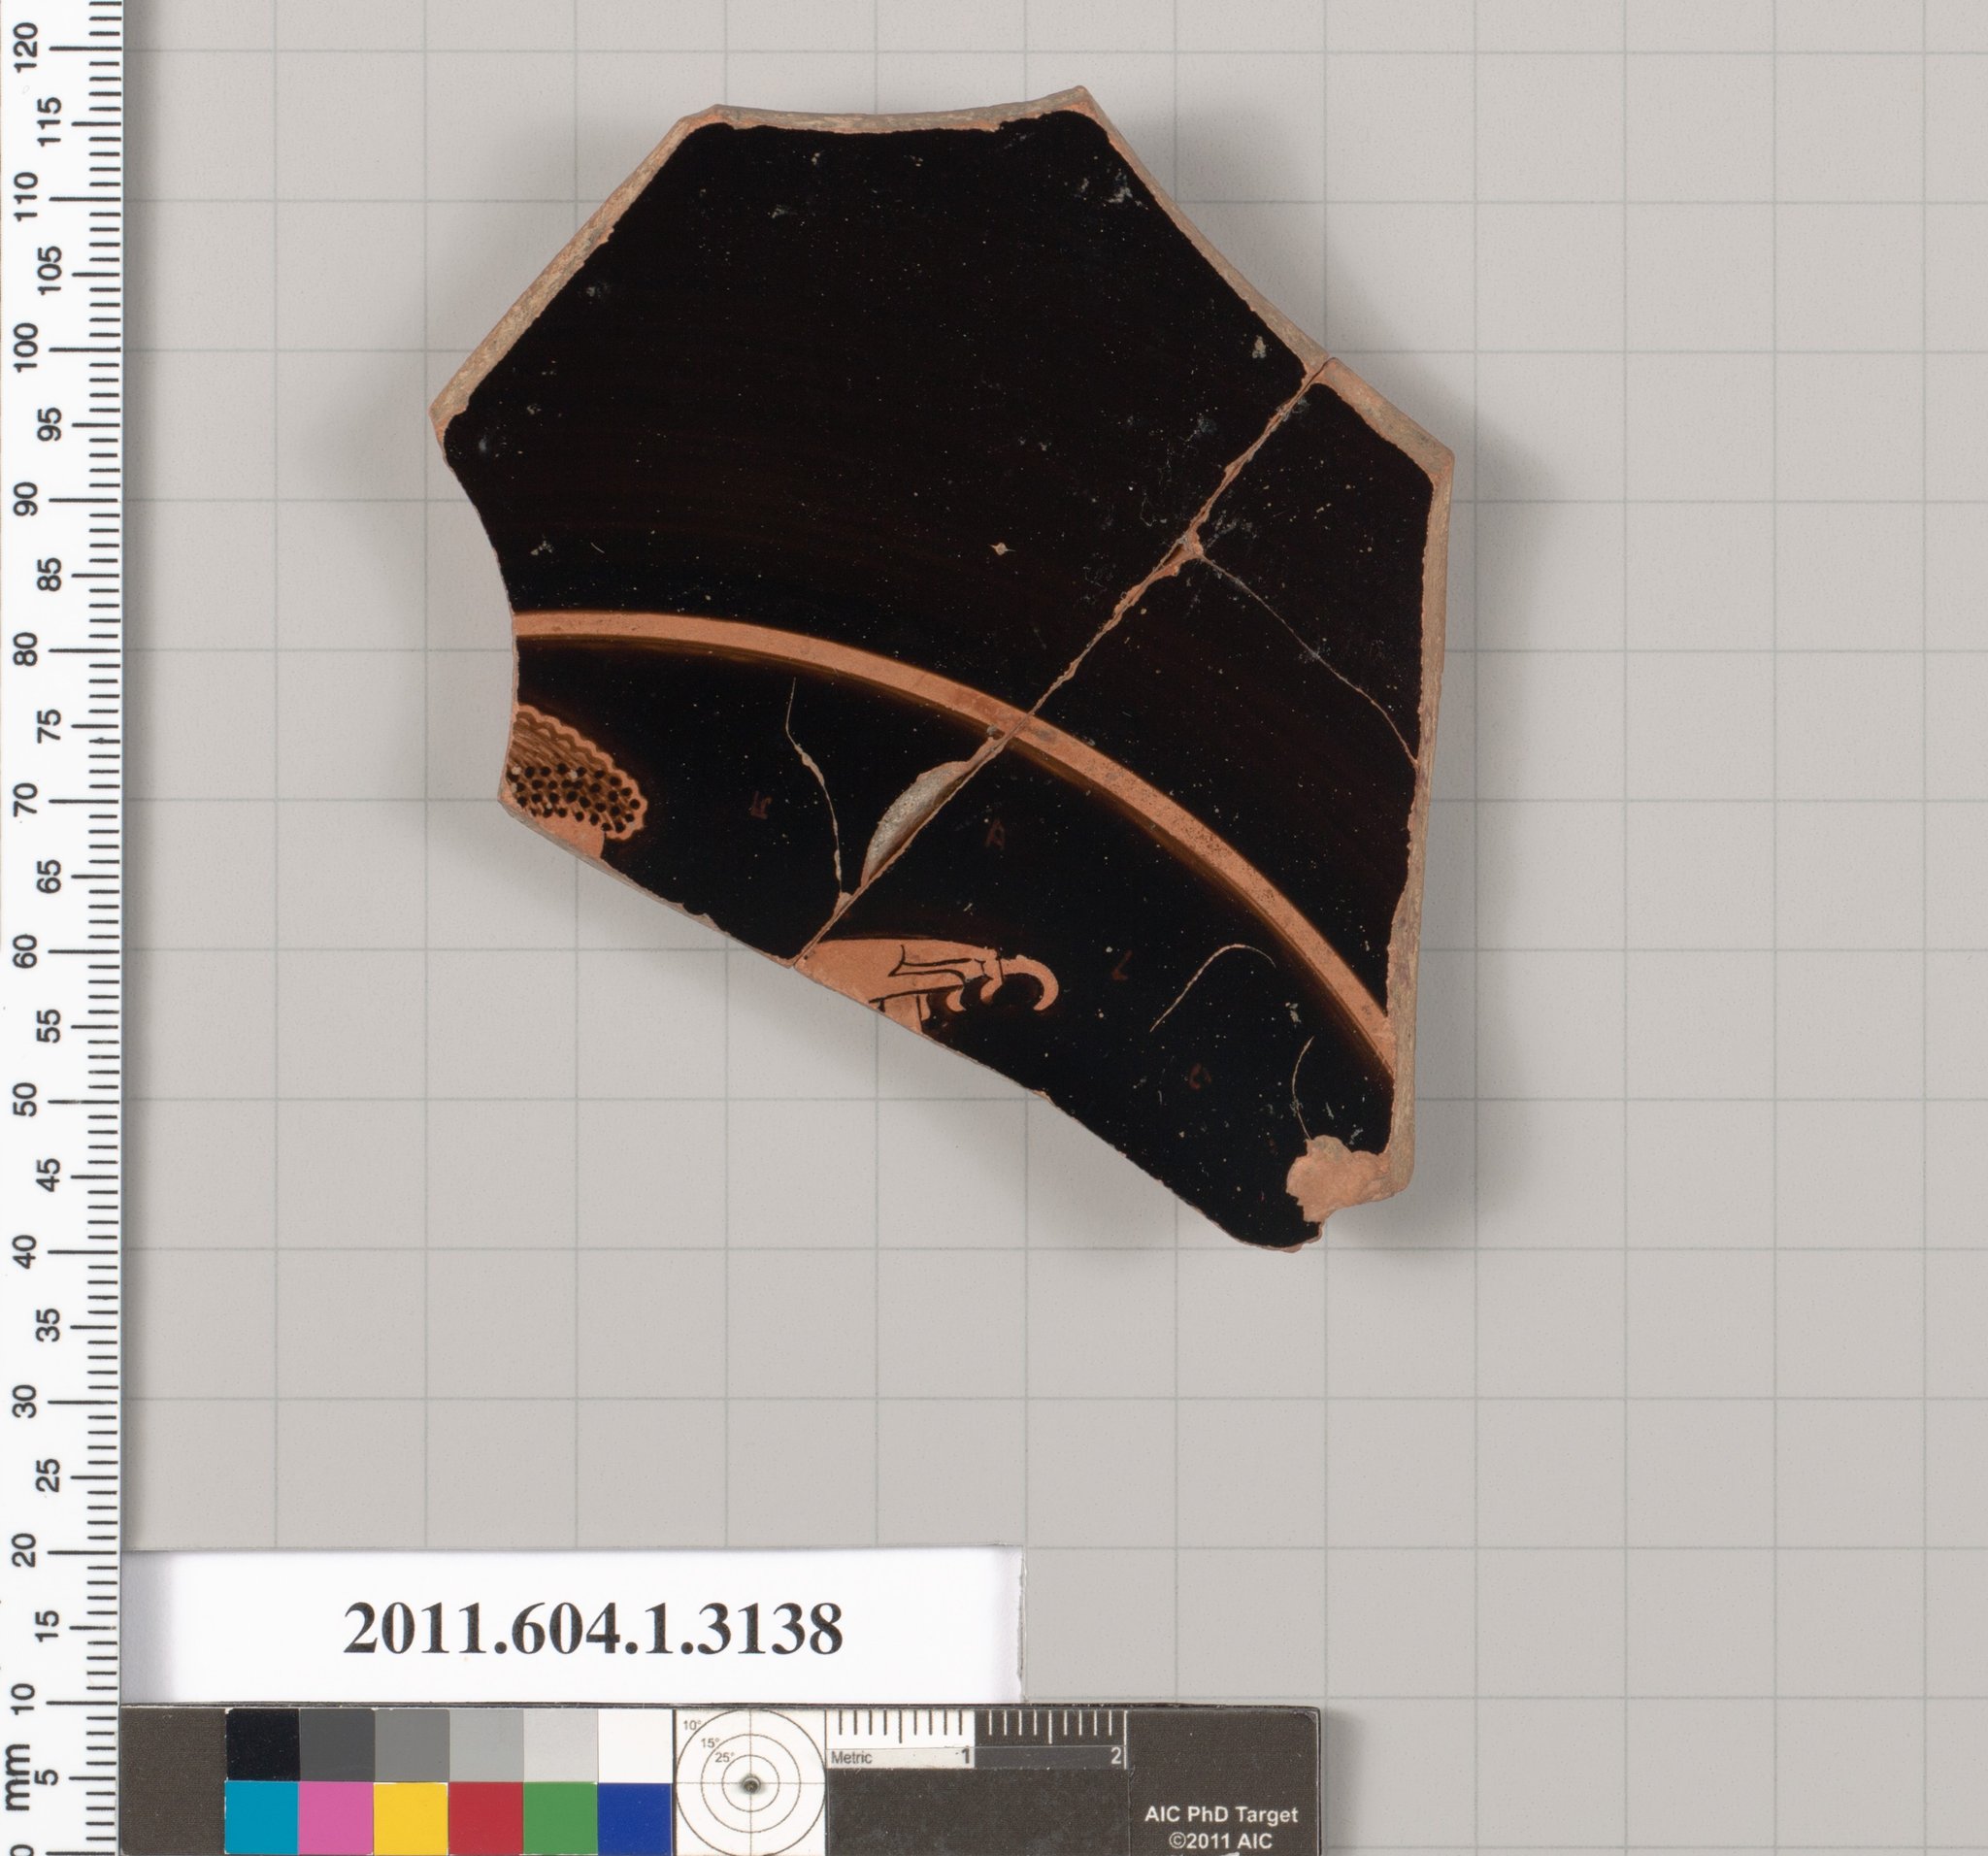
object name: kylix fragment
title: Terracotta fragment of a kylix (drinking cup)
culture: greek, attic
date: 500-490 BCE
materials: terracotta